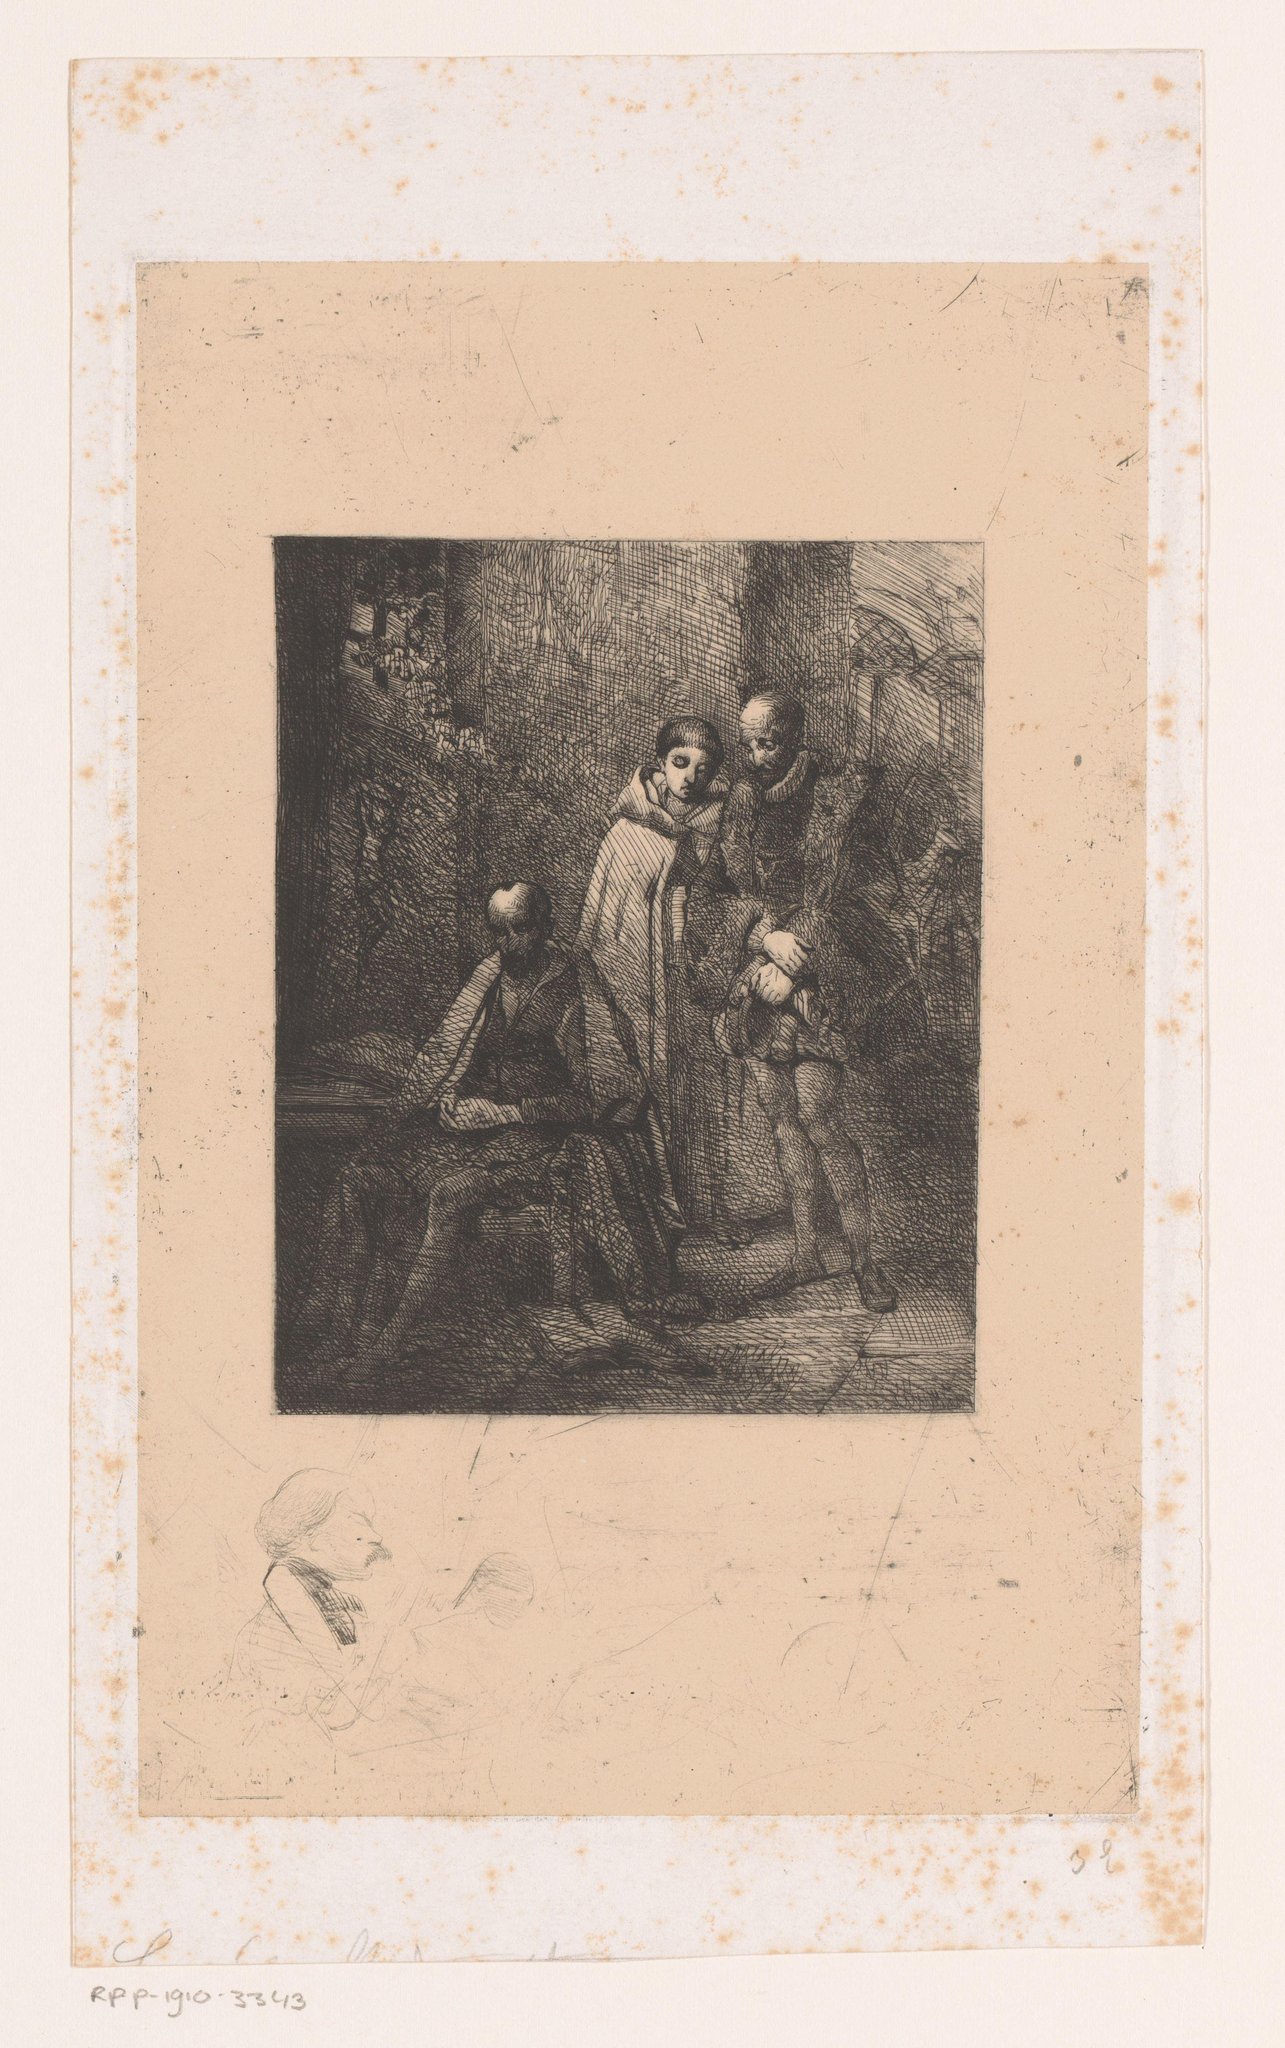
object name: print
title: Michel Eyquem de Montaigne bezoekt Torquato Tasso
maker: louis gallait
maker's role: draughtsman, painter, print maker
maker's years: 1810-1887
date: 1836-1837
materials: paper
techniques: etching, intaglio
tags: rome, torquato tasso, michel eyquem de montaigne, prison, jail, crucifix ~ personal devotion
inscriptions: collector's mark: Lugt 2228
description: De plaats waar de ontmoeting zich afspeelt is mogelijk een gevangenis, klooster of gekkenhuis.